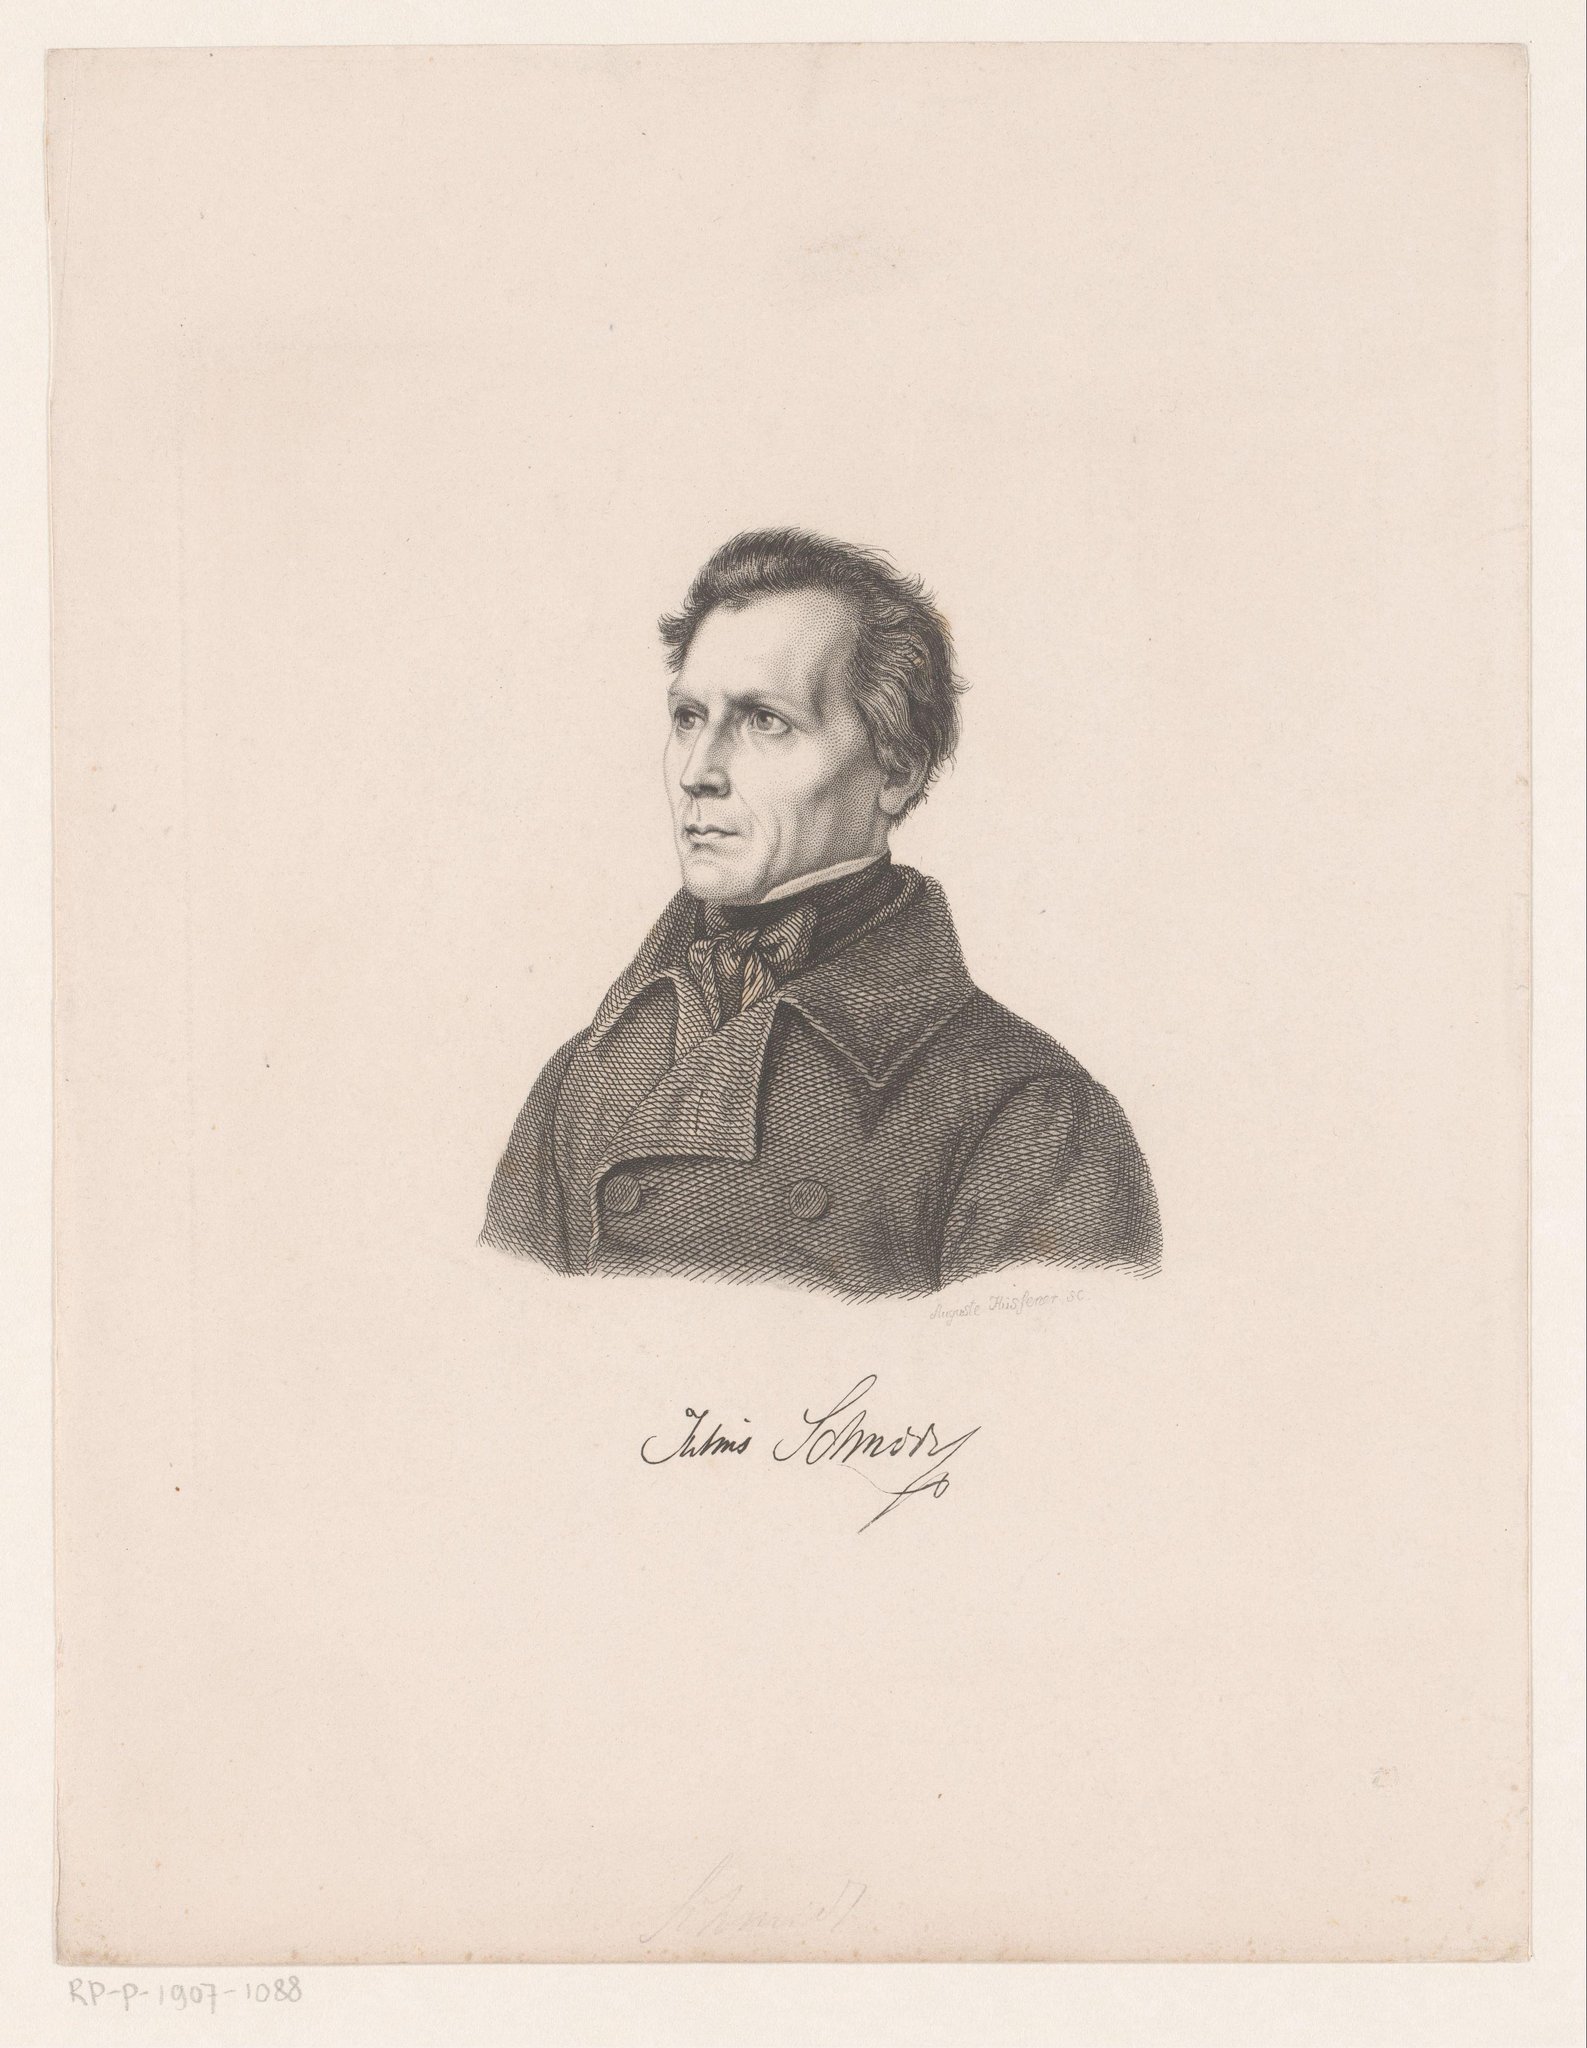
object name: print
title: Portret van Julius Schnorr von Carolsfeld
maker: auguste hüssener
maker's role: print maker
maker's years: 1789-1877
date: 1799-1877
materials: paper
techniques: etching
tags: draughtsman, julius schnorr von carolsfeld, historical persons, portrait, self-portrait of painter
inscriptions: collector's mark: Lugt 2228